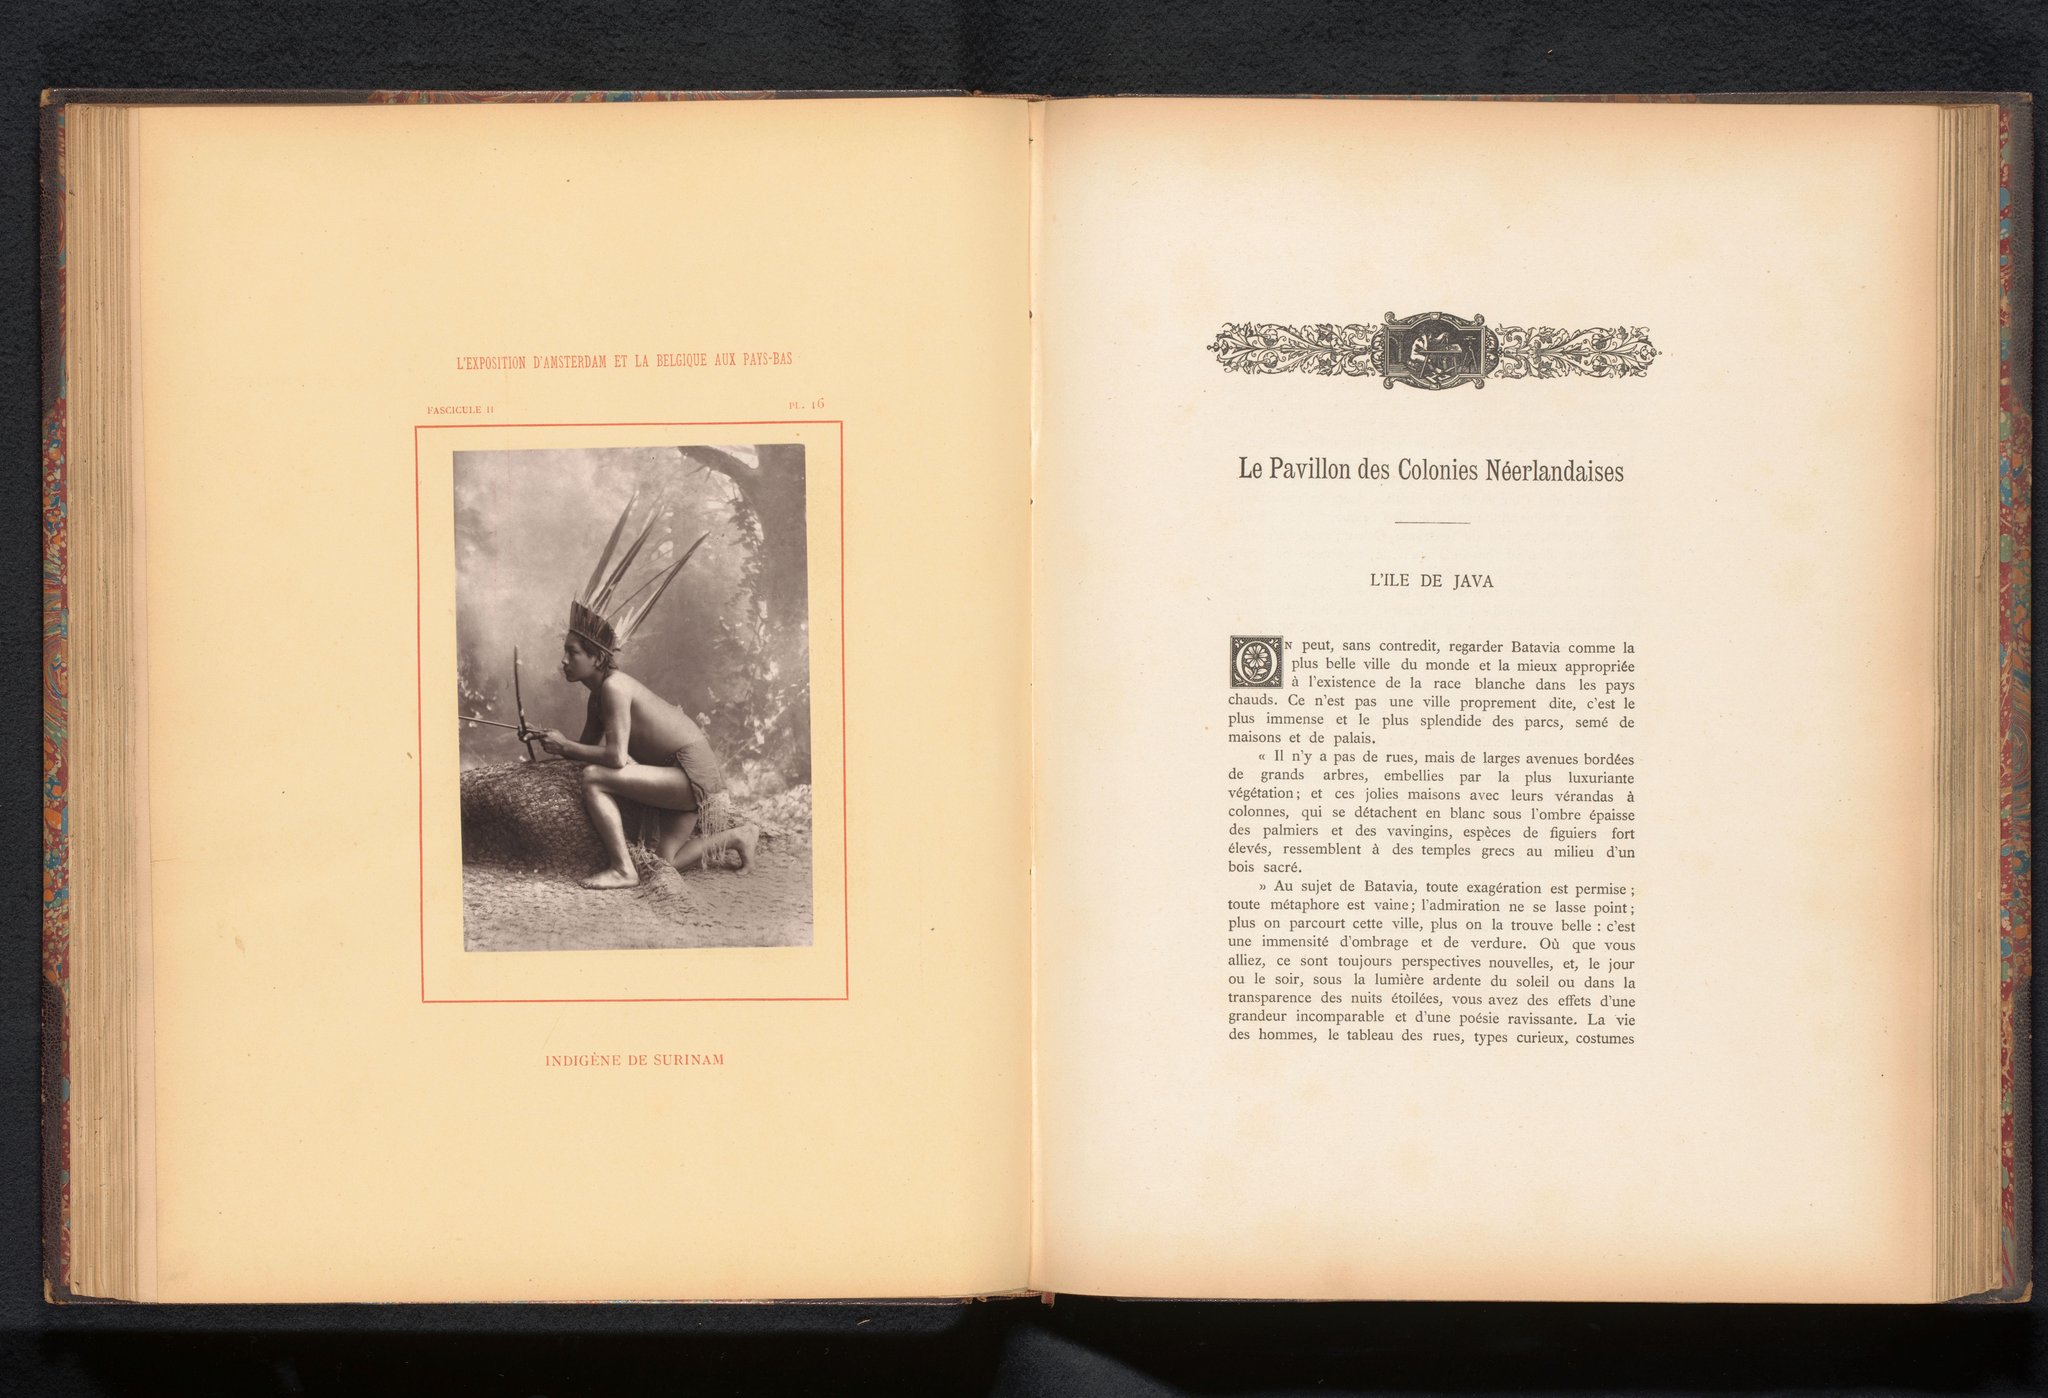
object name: photomechanical print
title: Surinaamse man met pijl en boog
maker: Anonymous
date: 1878-1883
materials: paper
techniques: woodburytype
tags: archer's weapons: bow and arrow, world fair, world exhibition, adult man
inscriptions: inscription: ‘Fascicule II/ PL. 16’